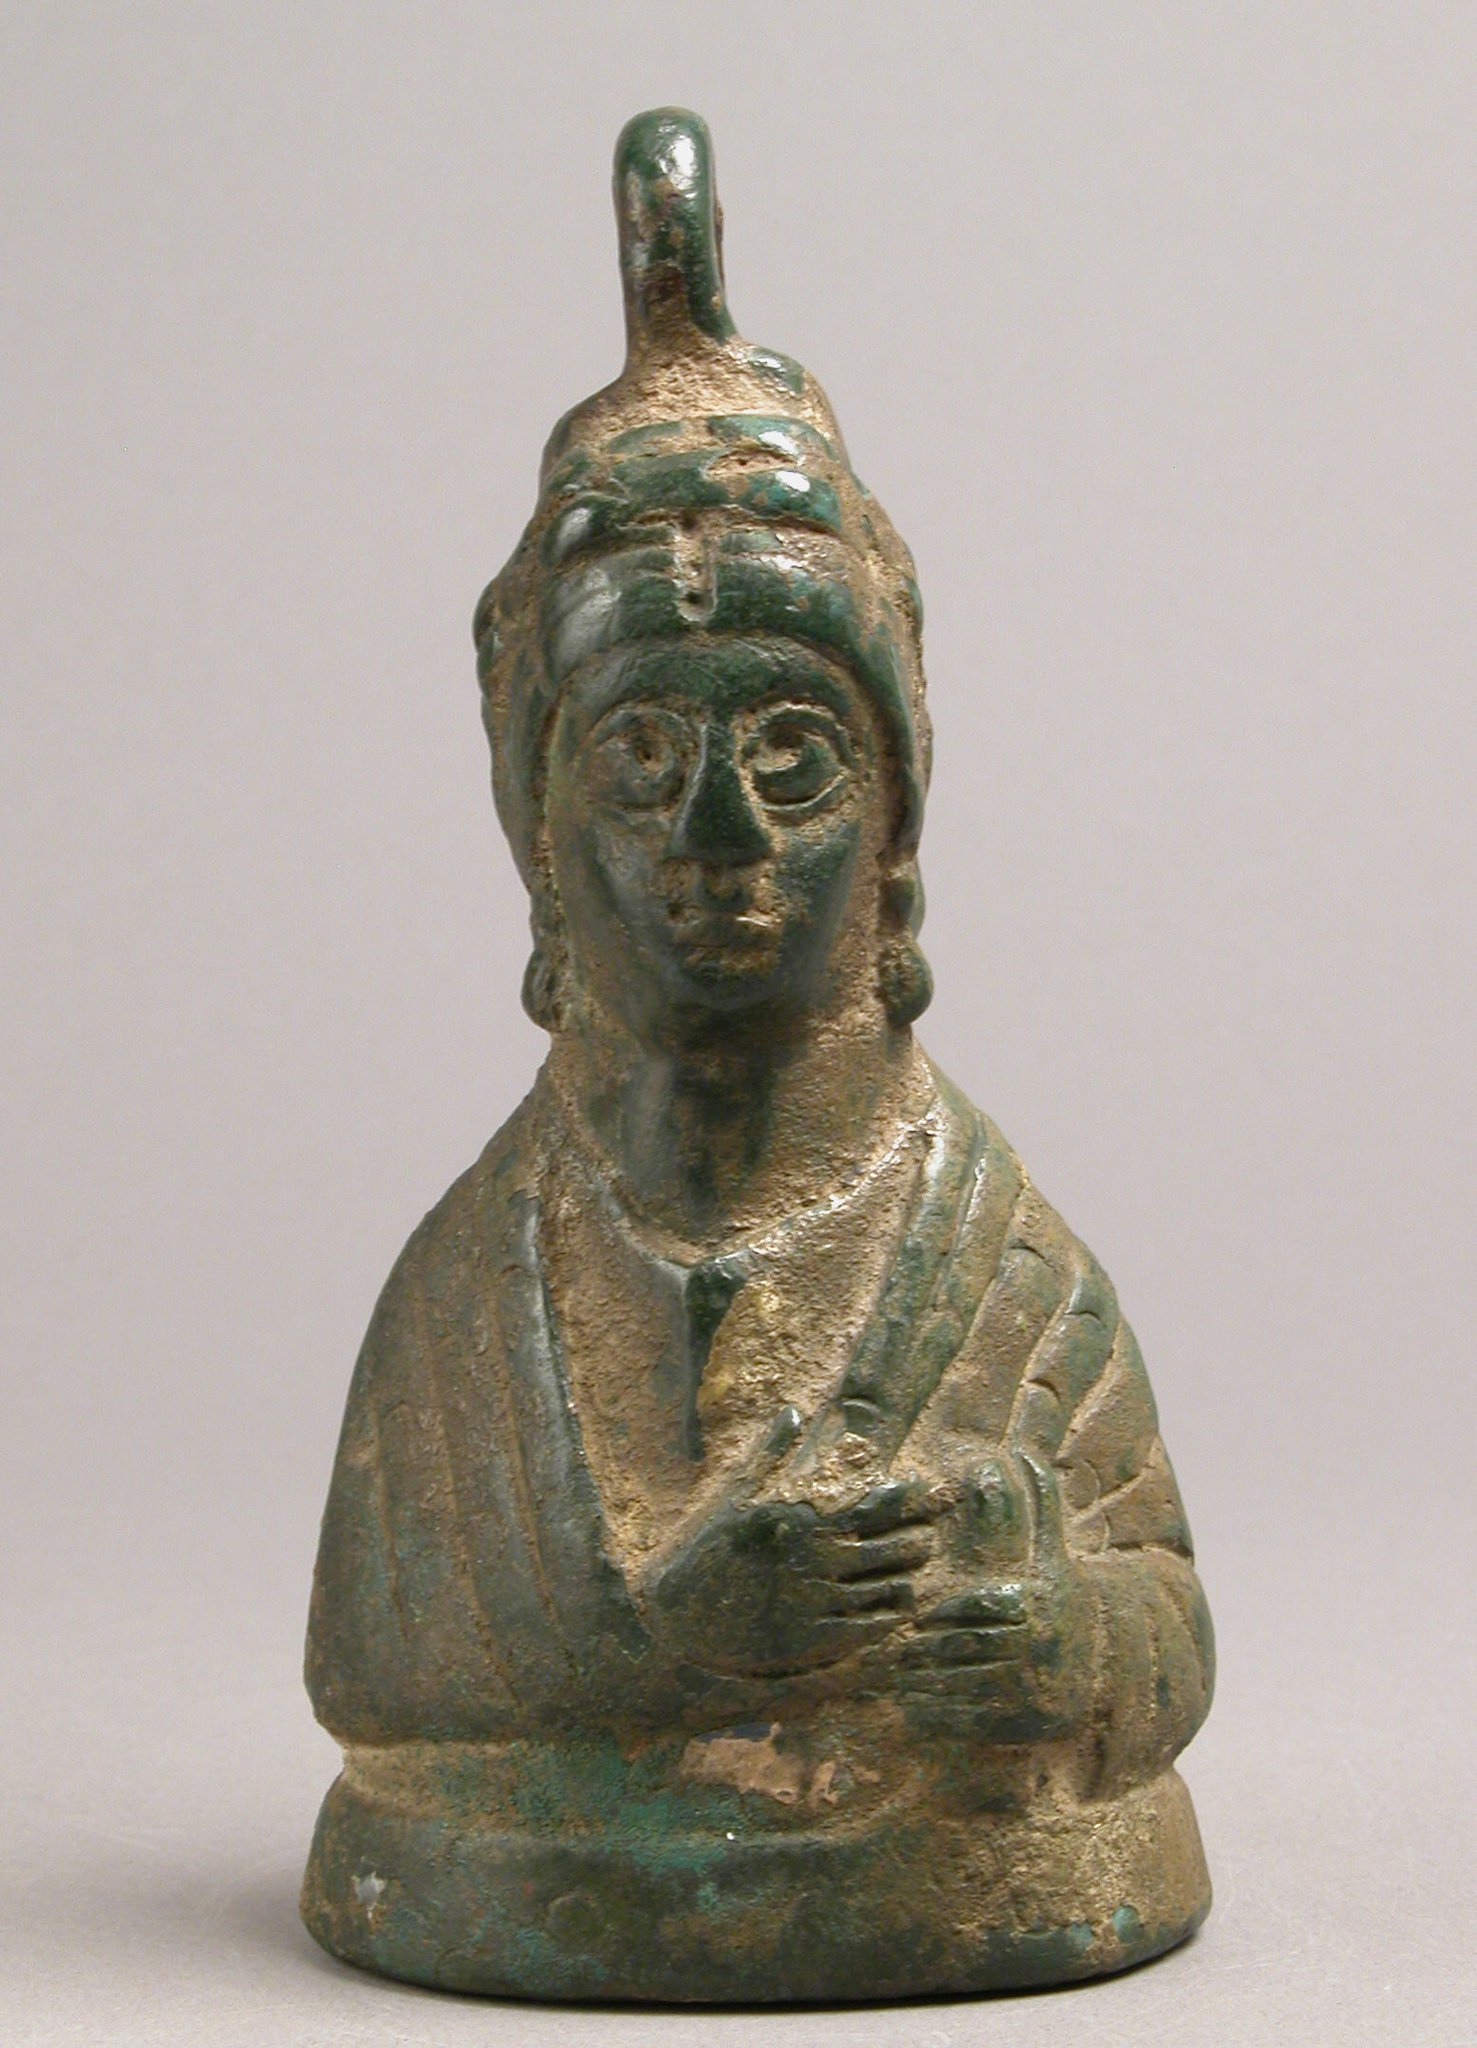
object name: steelyard weight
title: Weight in the Shape of a Byzantine Empress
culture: byzantine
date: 401-500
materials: copper alloy, metal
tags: women